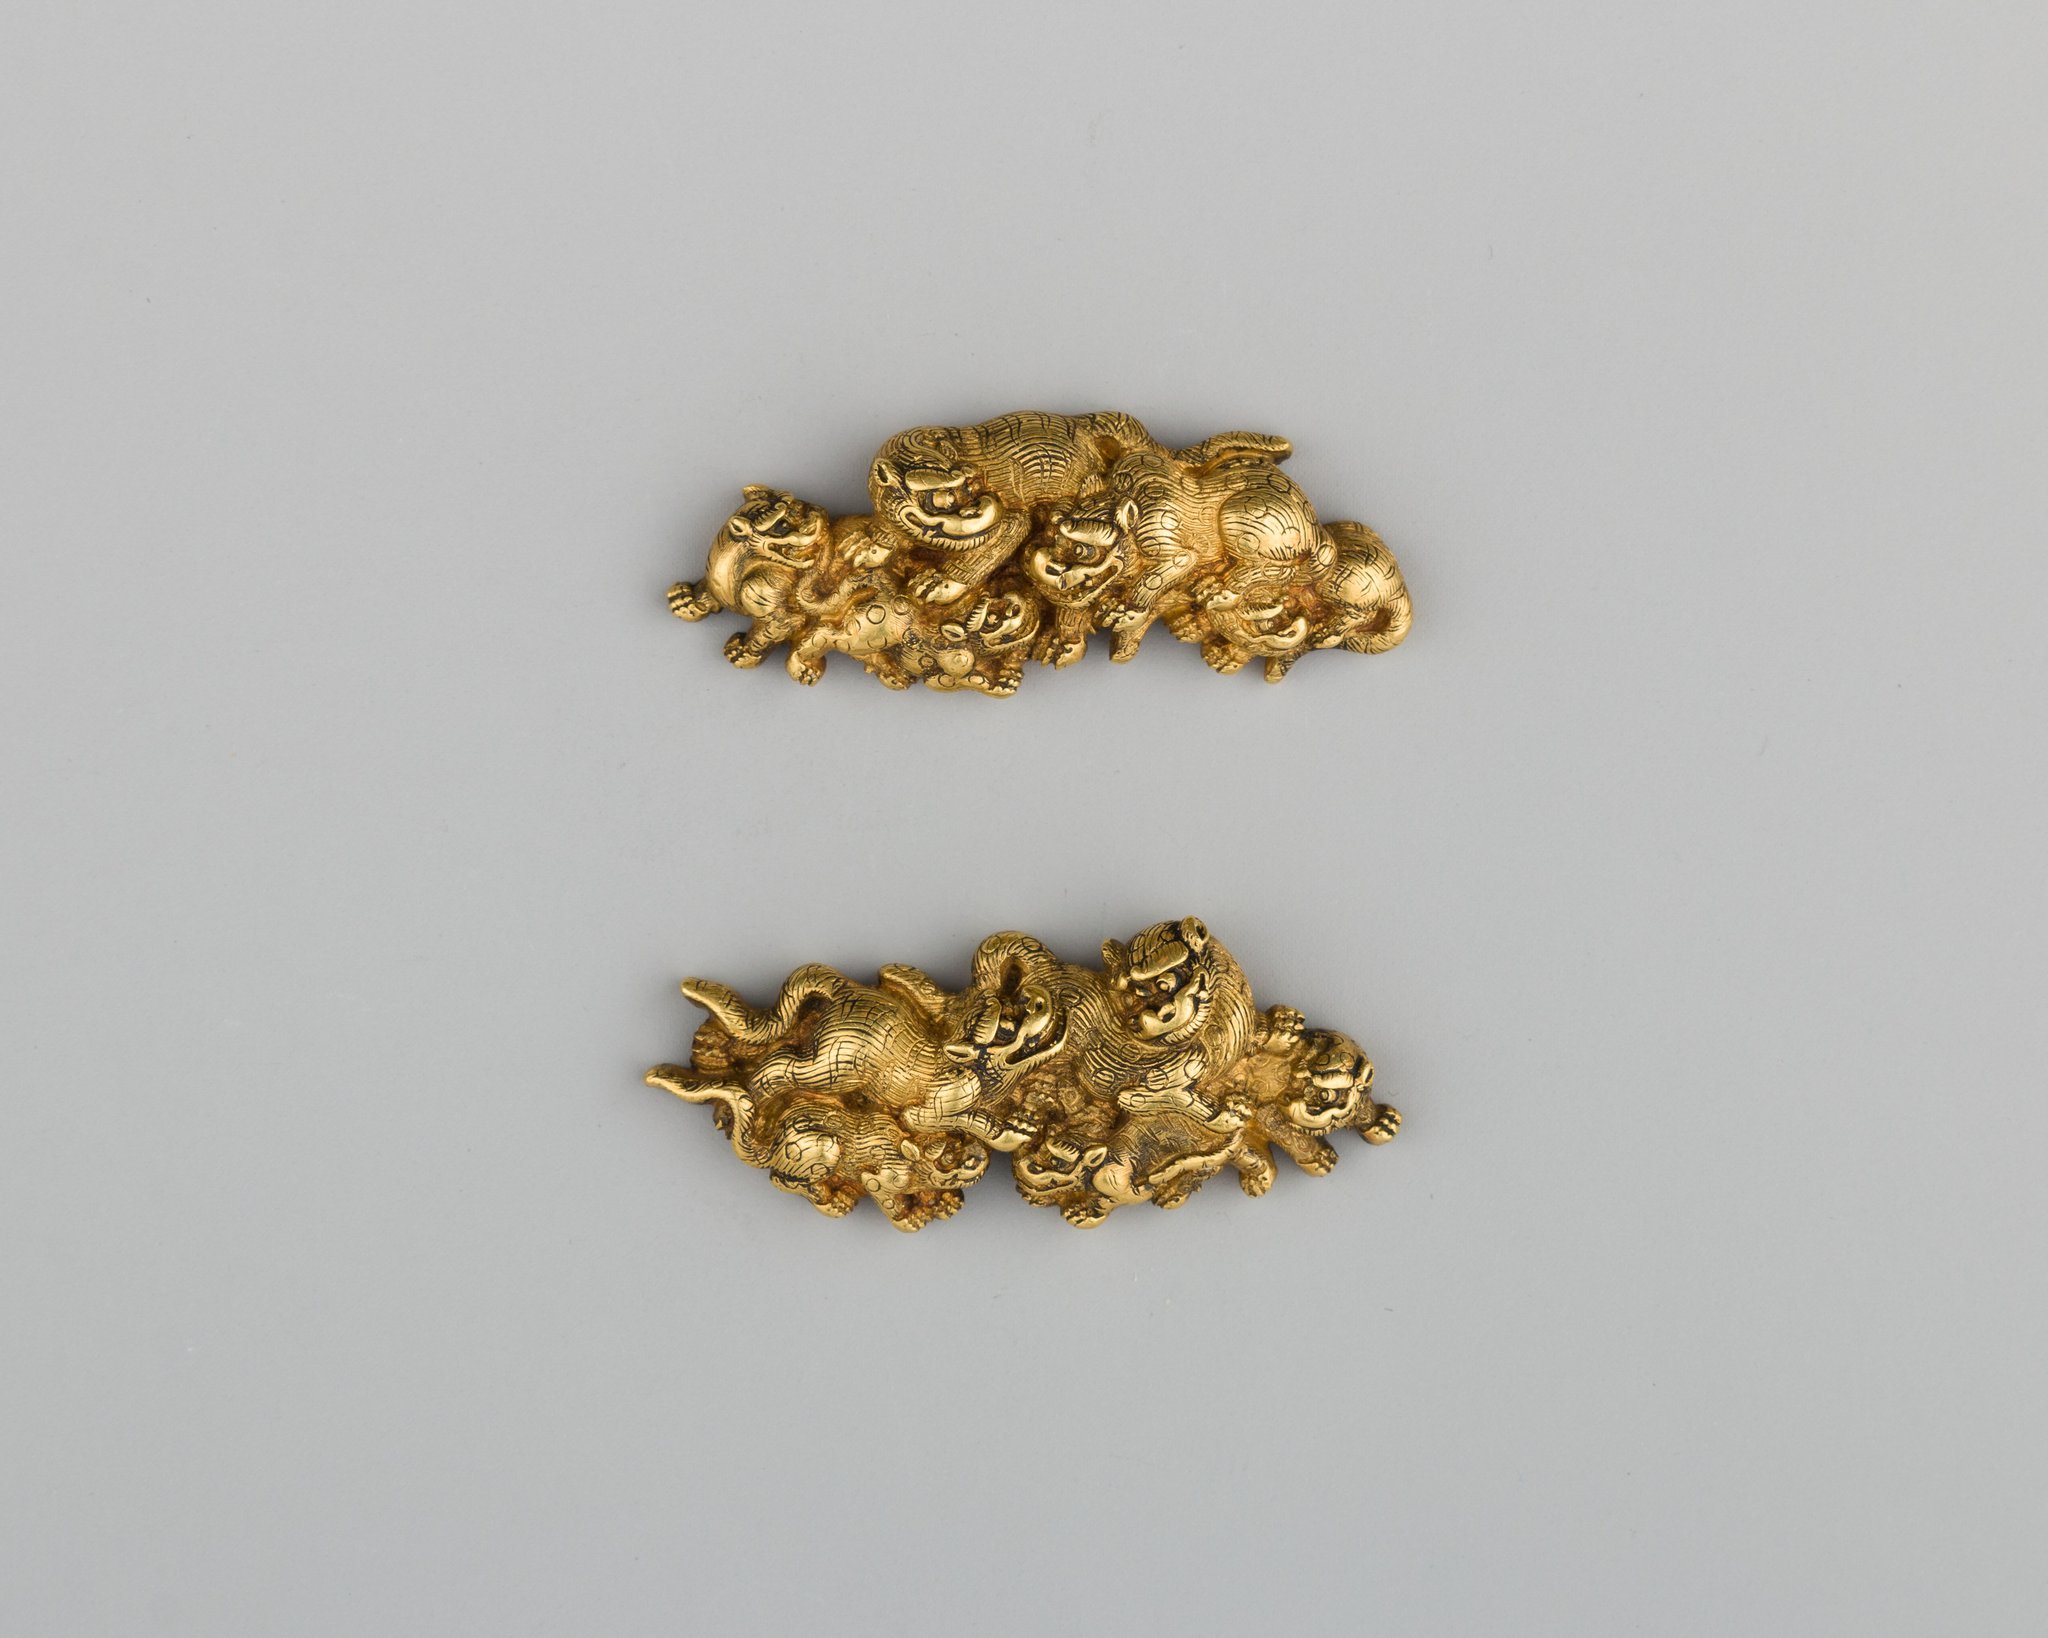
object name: pair of sword grip ornament menuki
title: Pair of Sword-Grip Ornaments (Menuki)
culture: japanese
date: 1701-1800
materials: gold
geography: japan